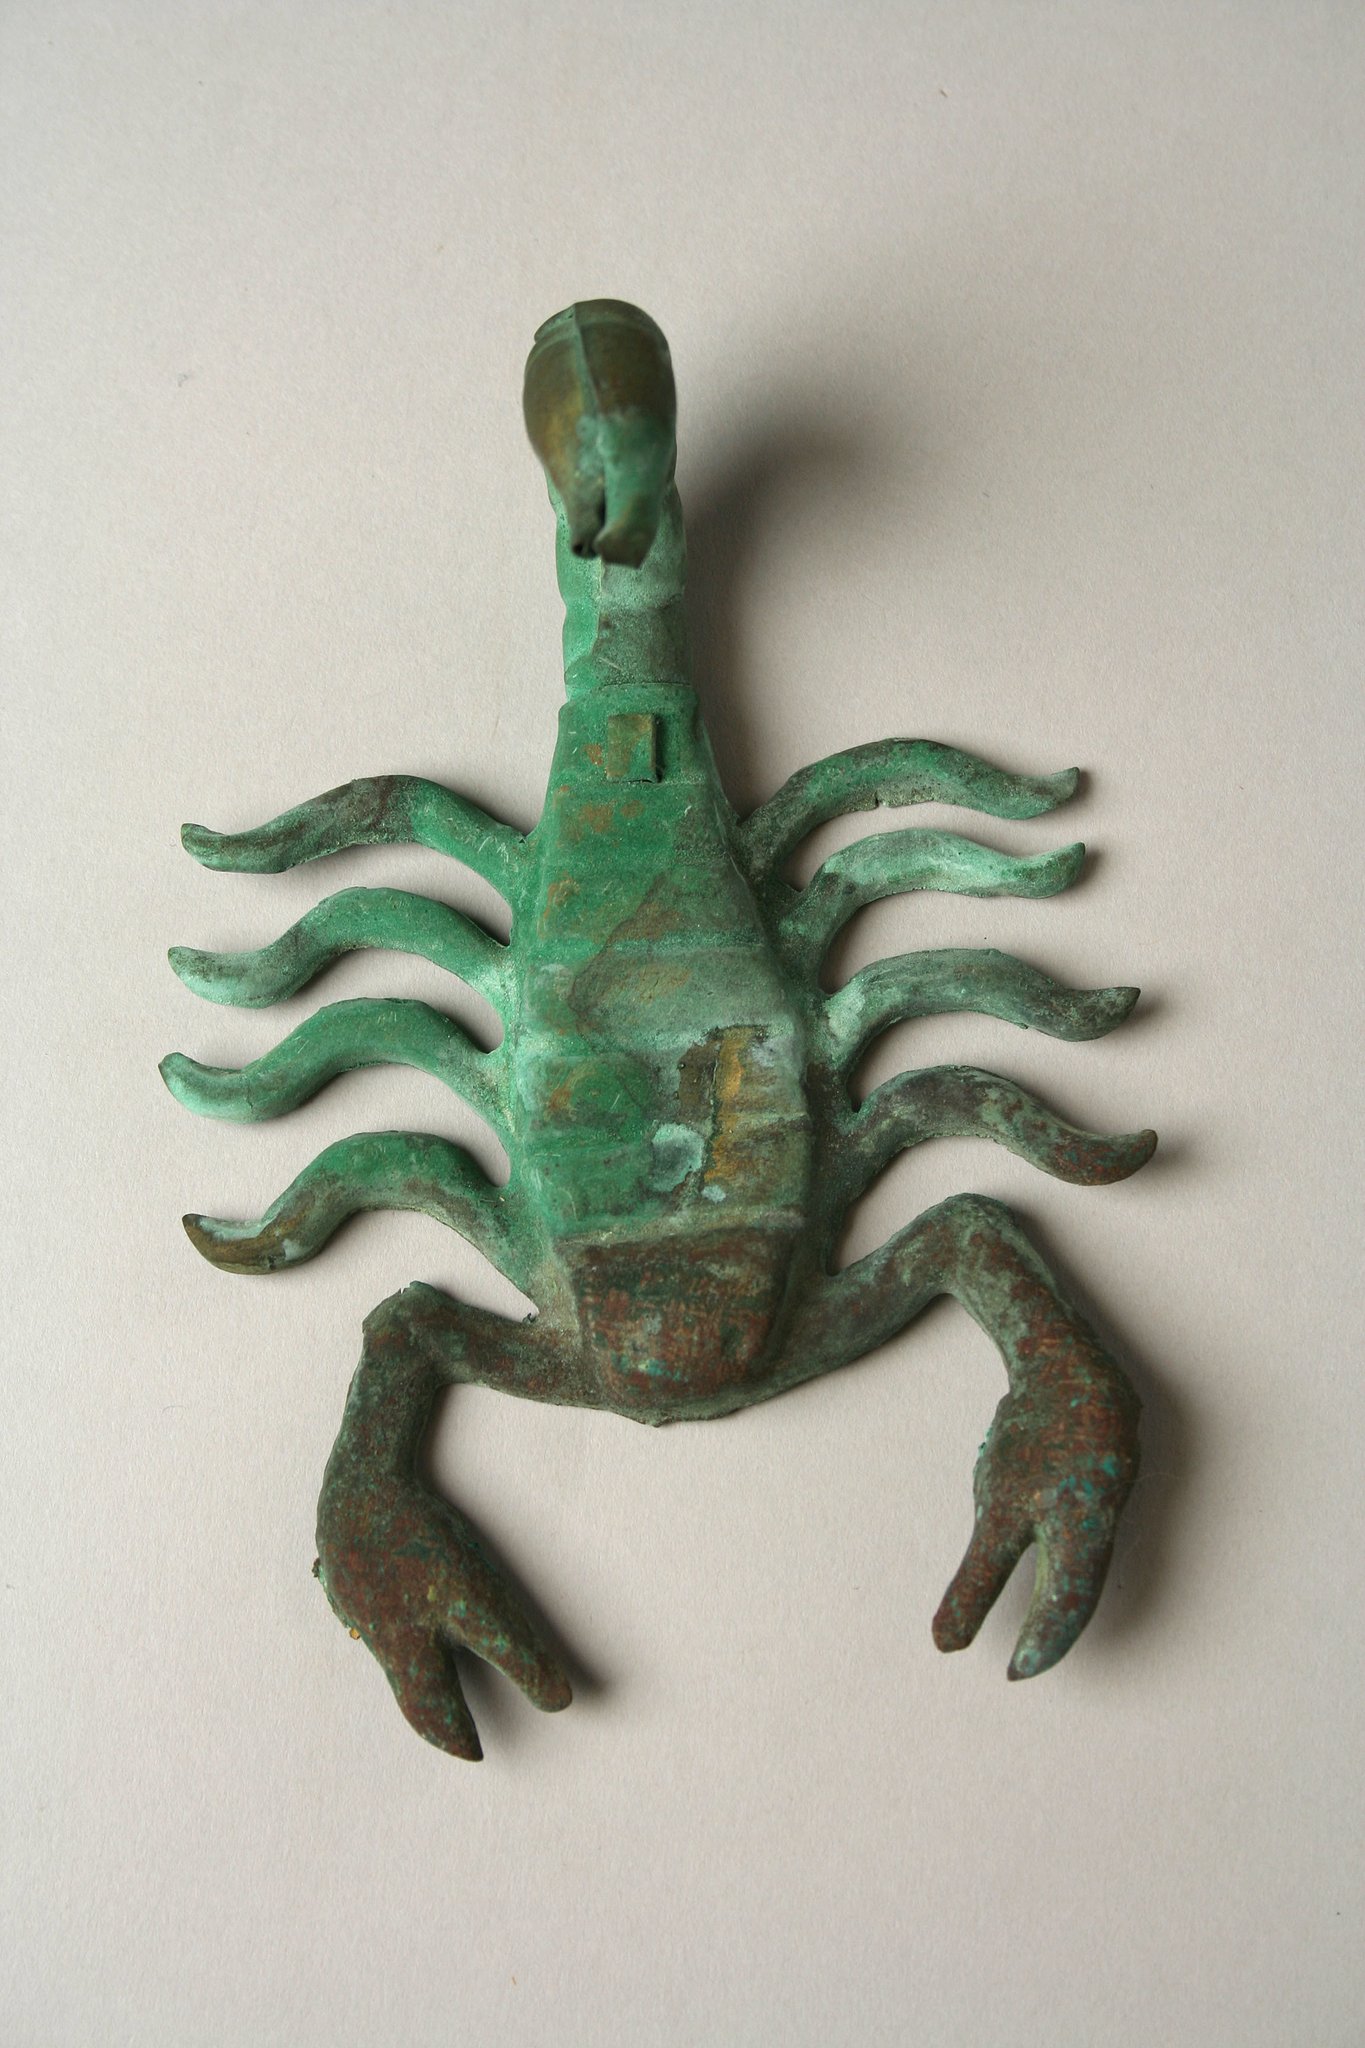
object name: ornament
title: Scorpion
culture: moche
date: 501-700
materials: gilt copper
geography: peru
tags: scorpions